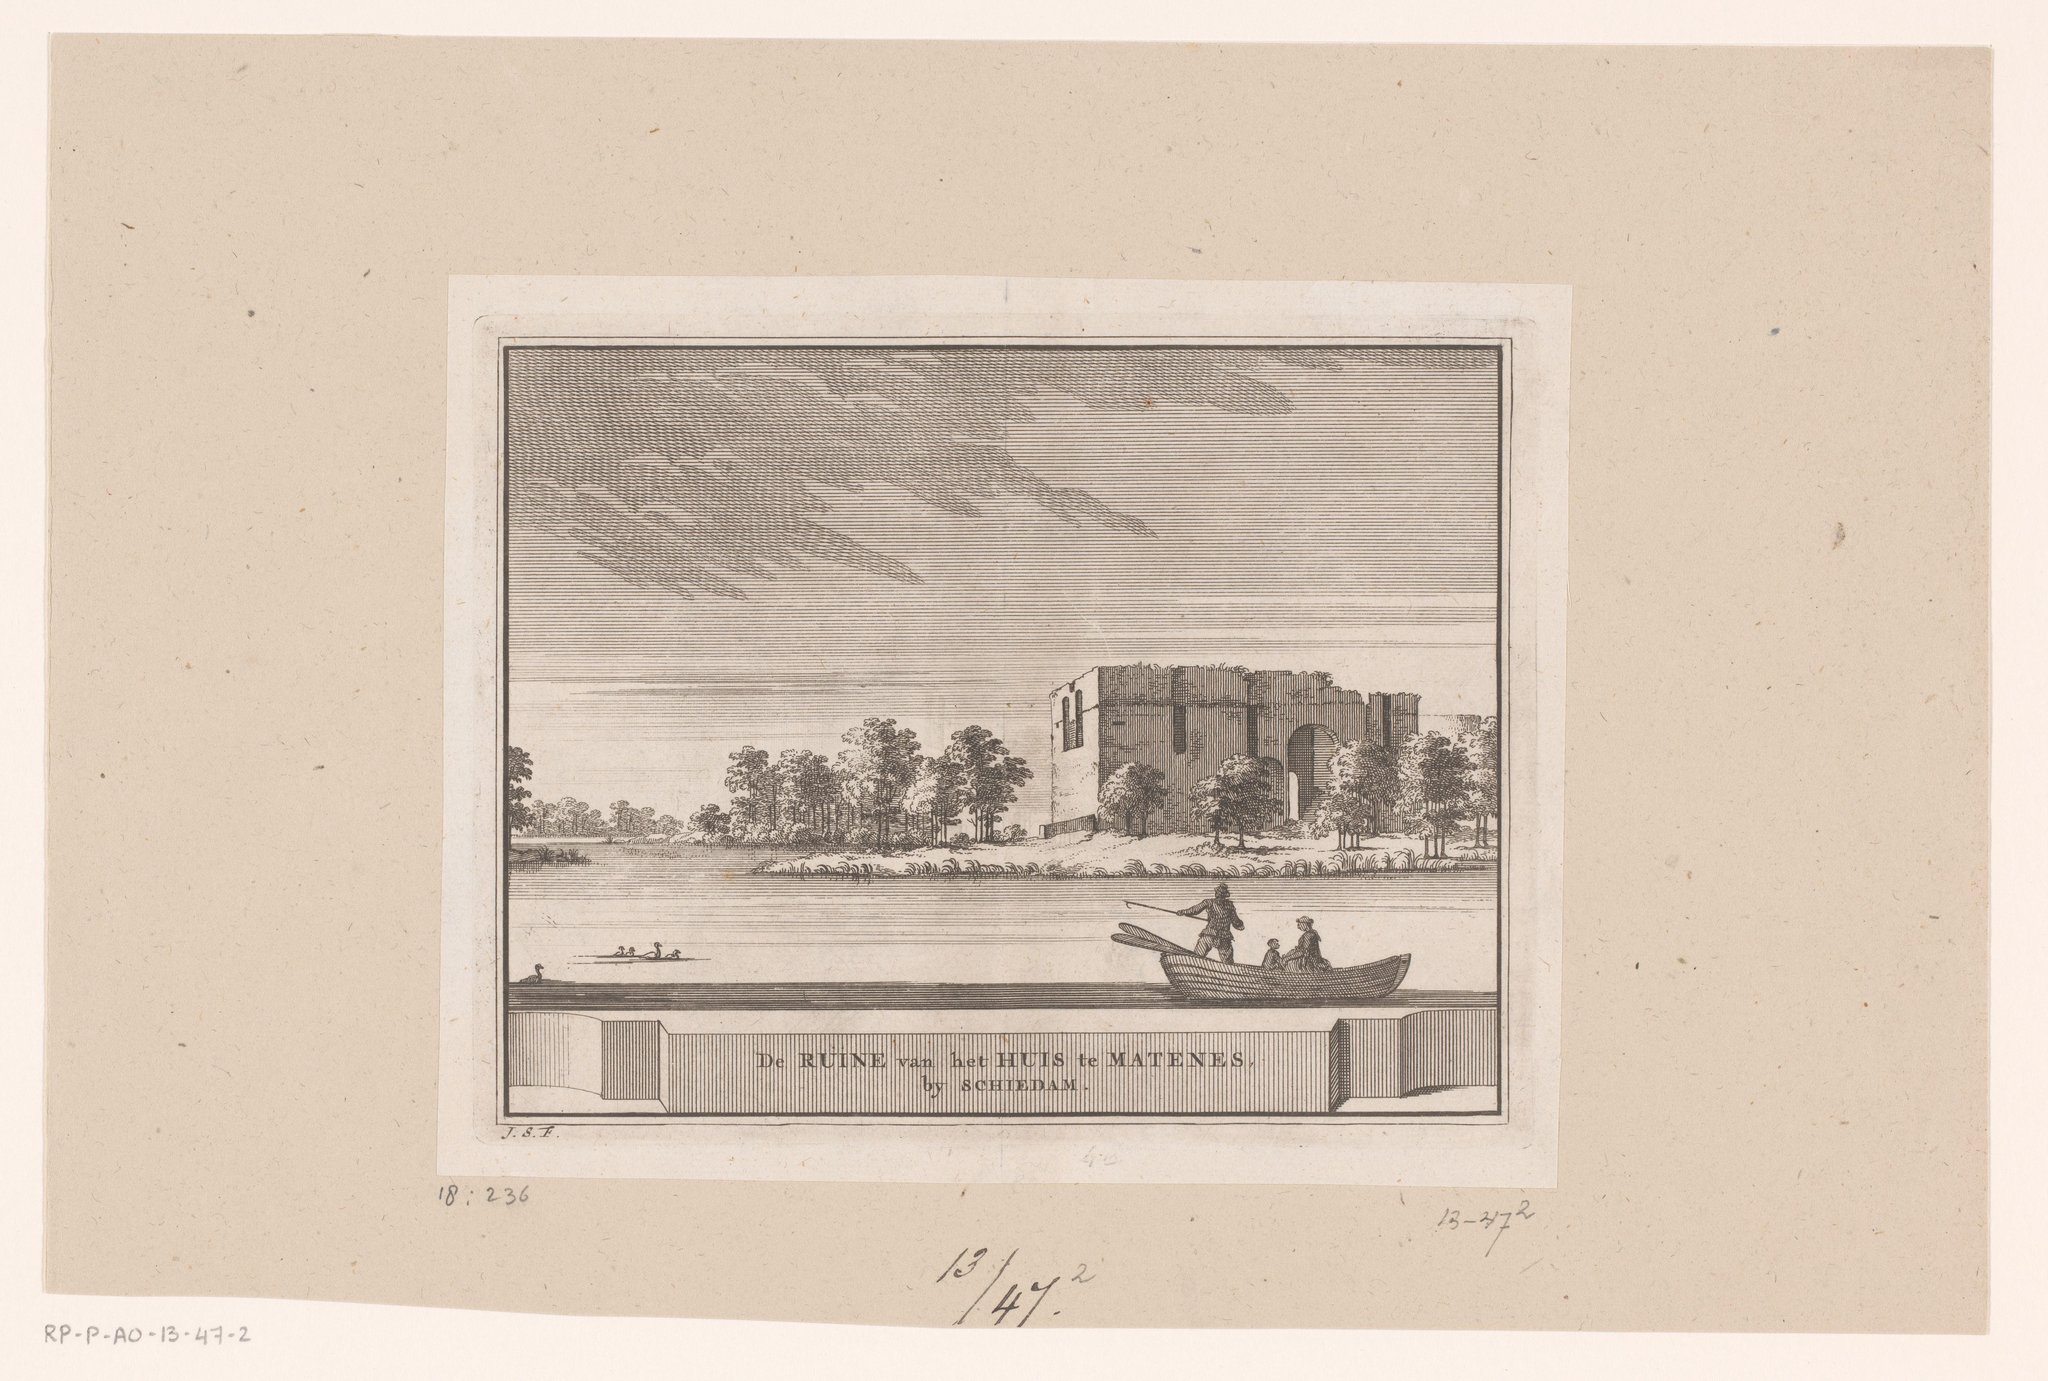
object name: print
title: De ruïne van het huis te Matenes by Schiedam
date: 1711-1774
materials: paper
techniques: engraving, etching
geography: amsterdam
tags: ruin of a dwelling, house, castle, etc.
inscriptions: collector's mark: Lugt 2228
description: Prent ook gebruikt in: Smids, Ludolf. Schatkamer der Nederlandsse oudheden; of woordenboek, behelsende Nederlands steden en dorpen, kasteelen, sloten en heeren huysen (…). Amsterdam: Pieter de Coup, 1711, tussen p. 224 en 225. Het is ook mogelijk dat deze prent uit de tweede (1737) of derde (1774) druk komt, of uit een uitgave met alleen de prenten: Nederlandsche oudheden, bestaande in zestig verbeeldingen (...) gelegen in Holland, 't Sticht van Utrecht en Gelderland enz. Amsterdam: Hendrik Bosch, 1721.